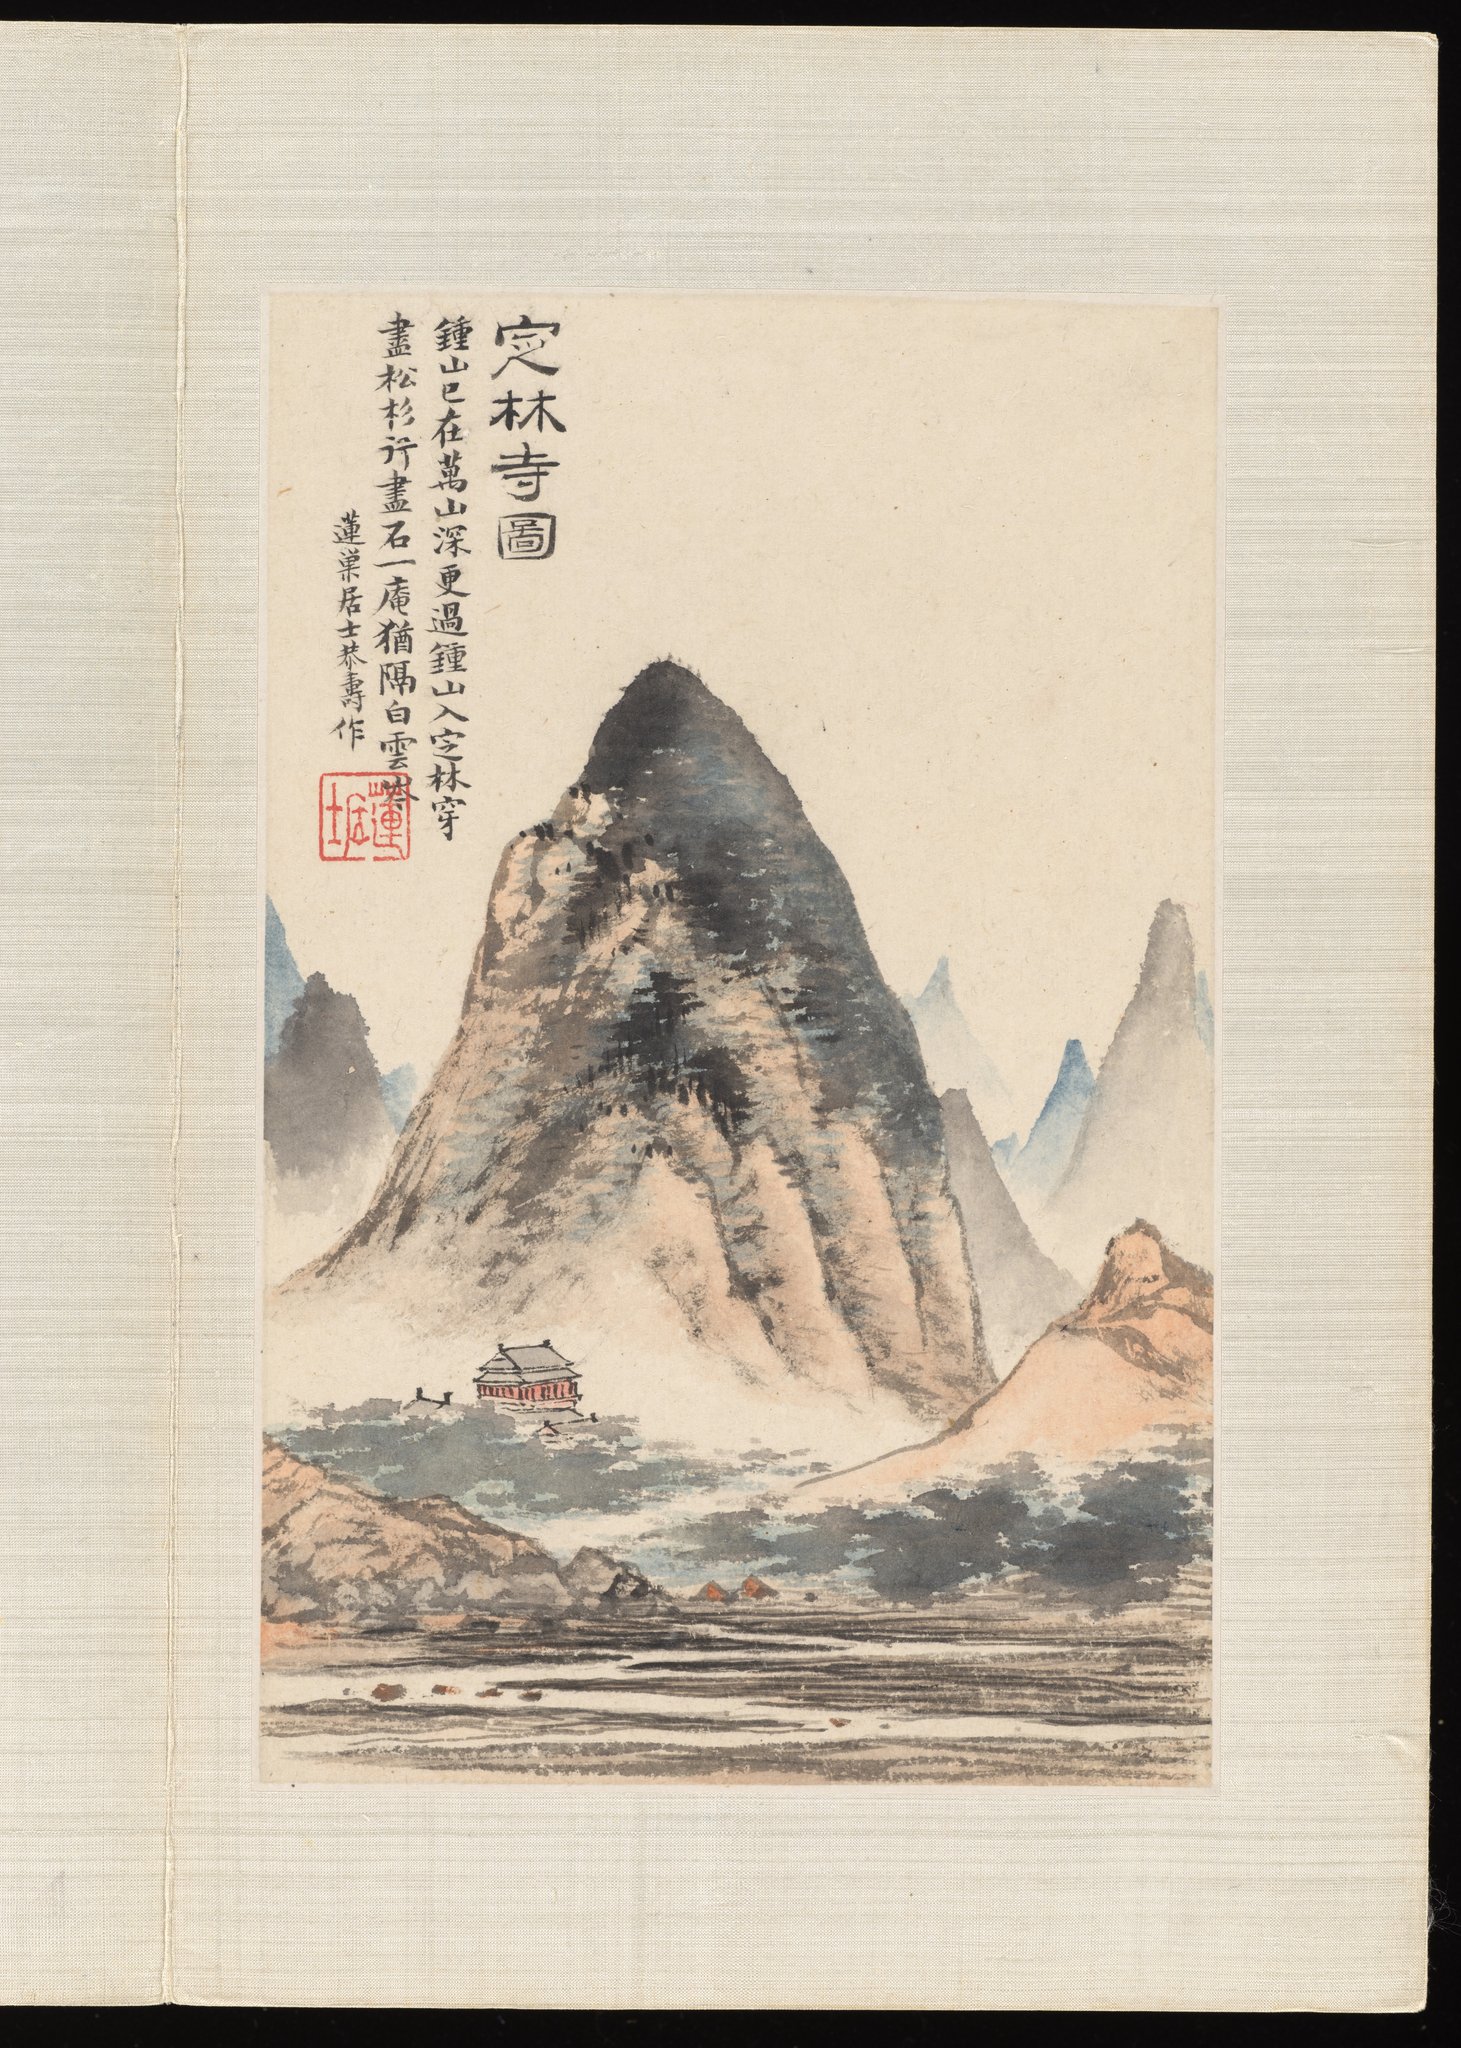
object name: album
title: Landscapes after old masters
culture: chinese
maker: pan gongshou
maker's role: artist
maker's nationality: chinese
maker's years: 1741-1794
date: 1783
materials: ink, paper